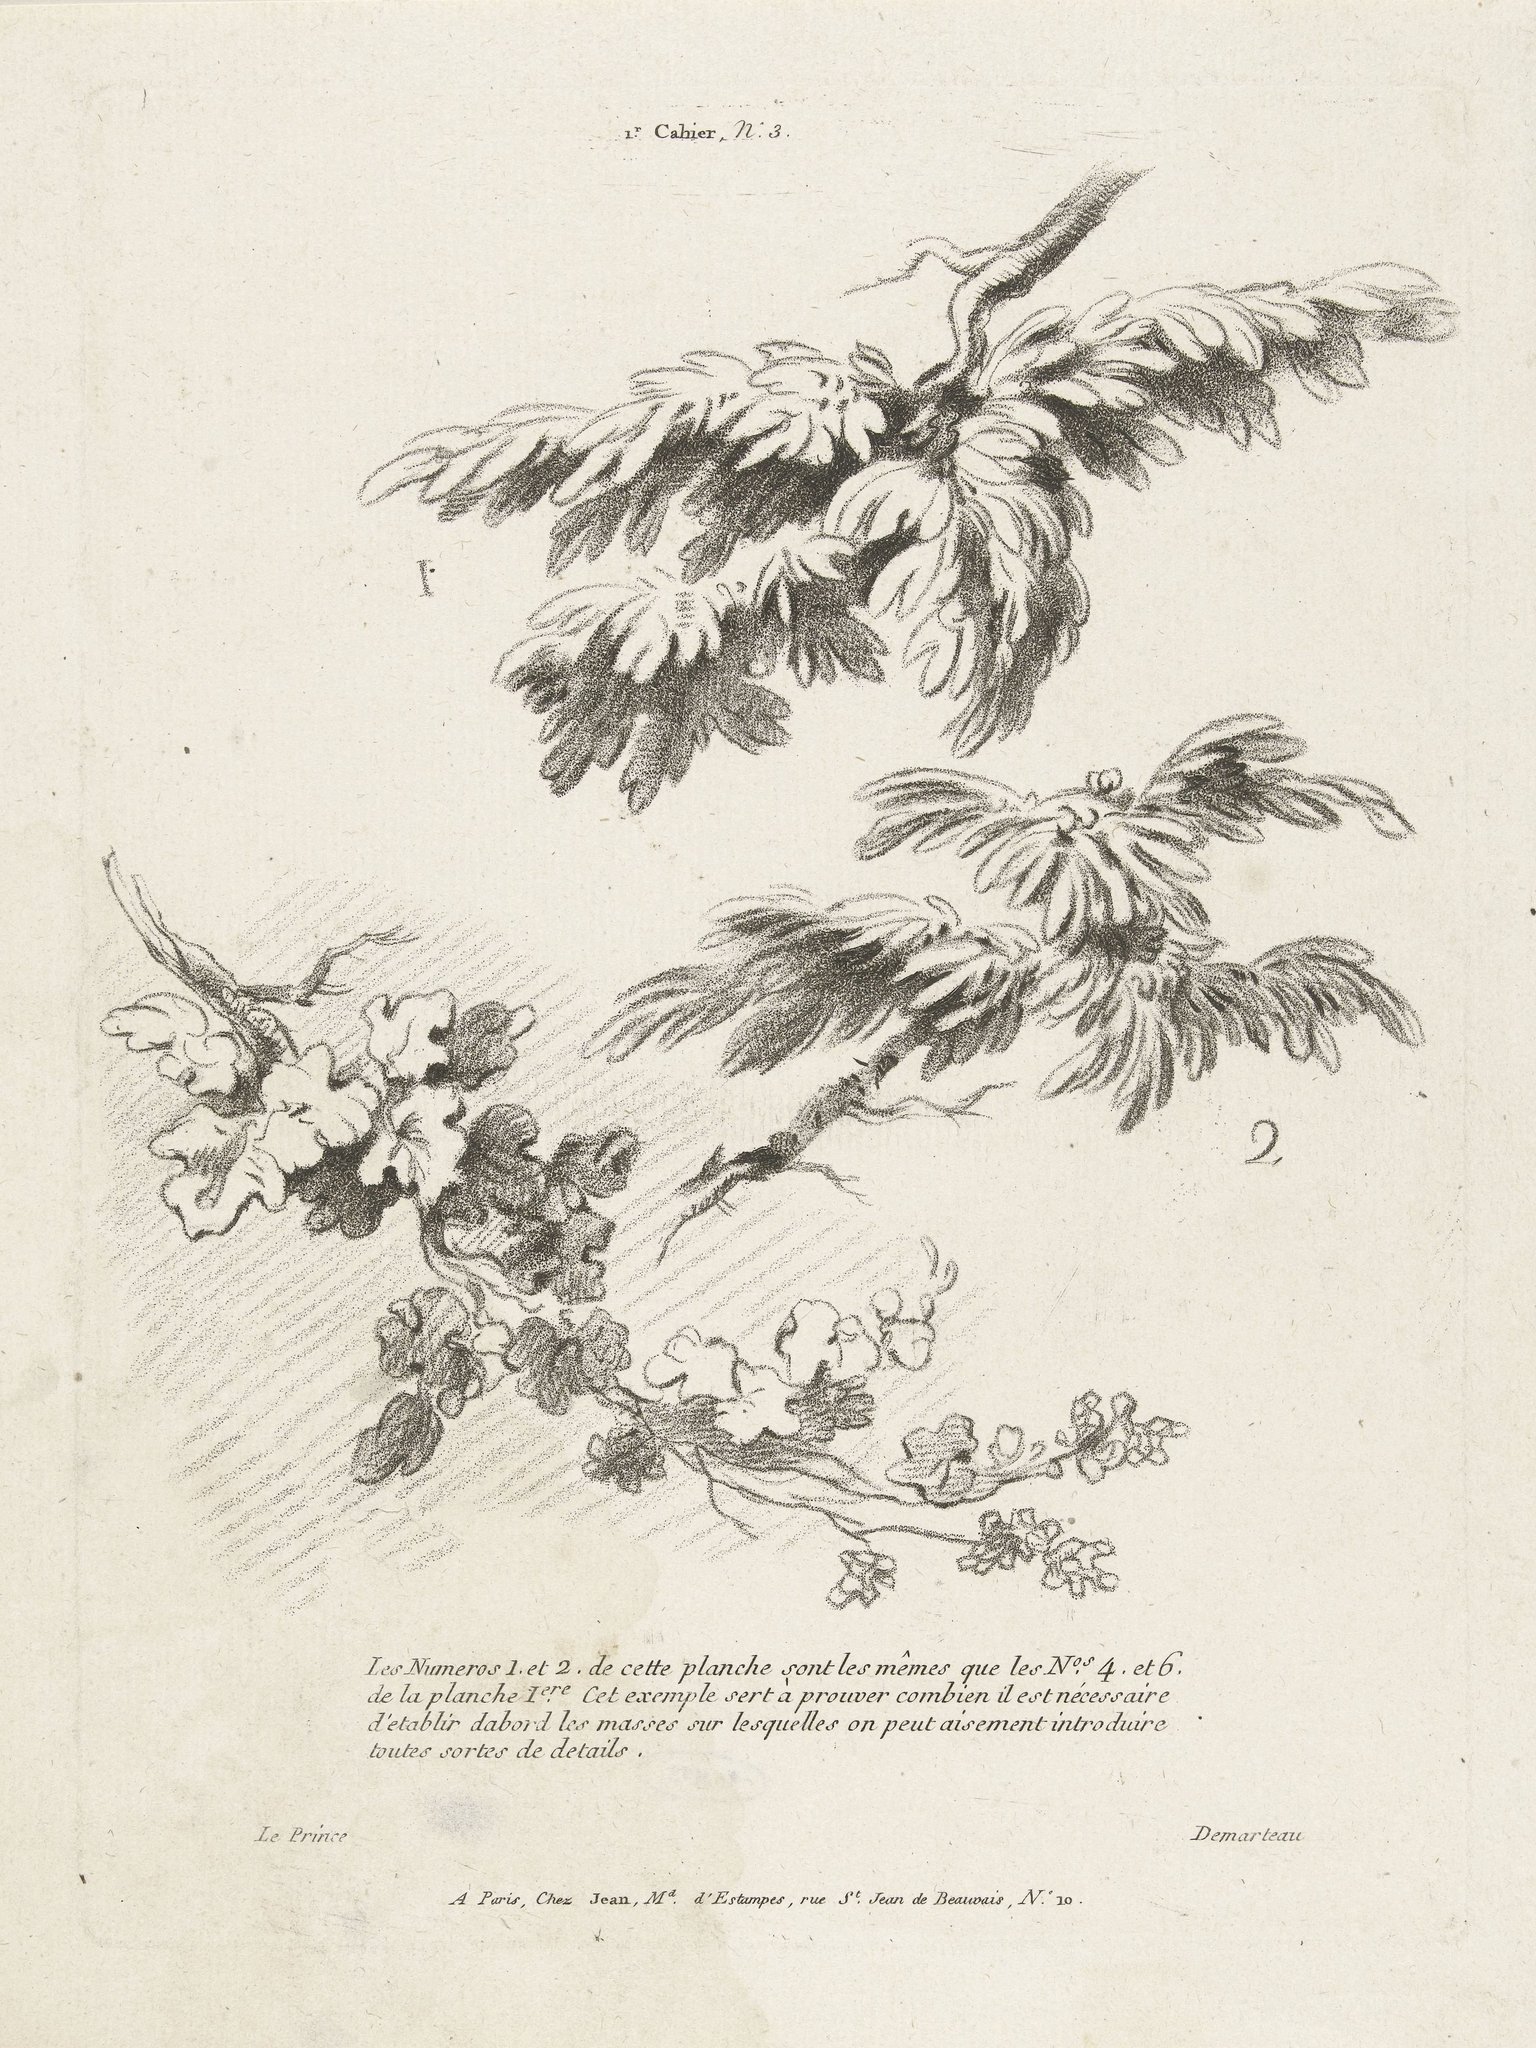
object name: print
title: 1er Cahier de paysage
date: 1732-1776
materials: paper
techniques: printmaking, etching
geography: paris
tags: trees (+ parts of plants)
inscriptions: collector's mark: Lugt 2228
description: Studie van drie takken met bladeren. Vier regels Franse tekst verklaren de verschillende manieren van tekenen met krijt om details tot uitdrukking te brengen. Prent uit serie met onbekend aantal prenten ter instructie van het tekenen van landschappen in krijt.